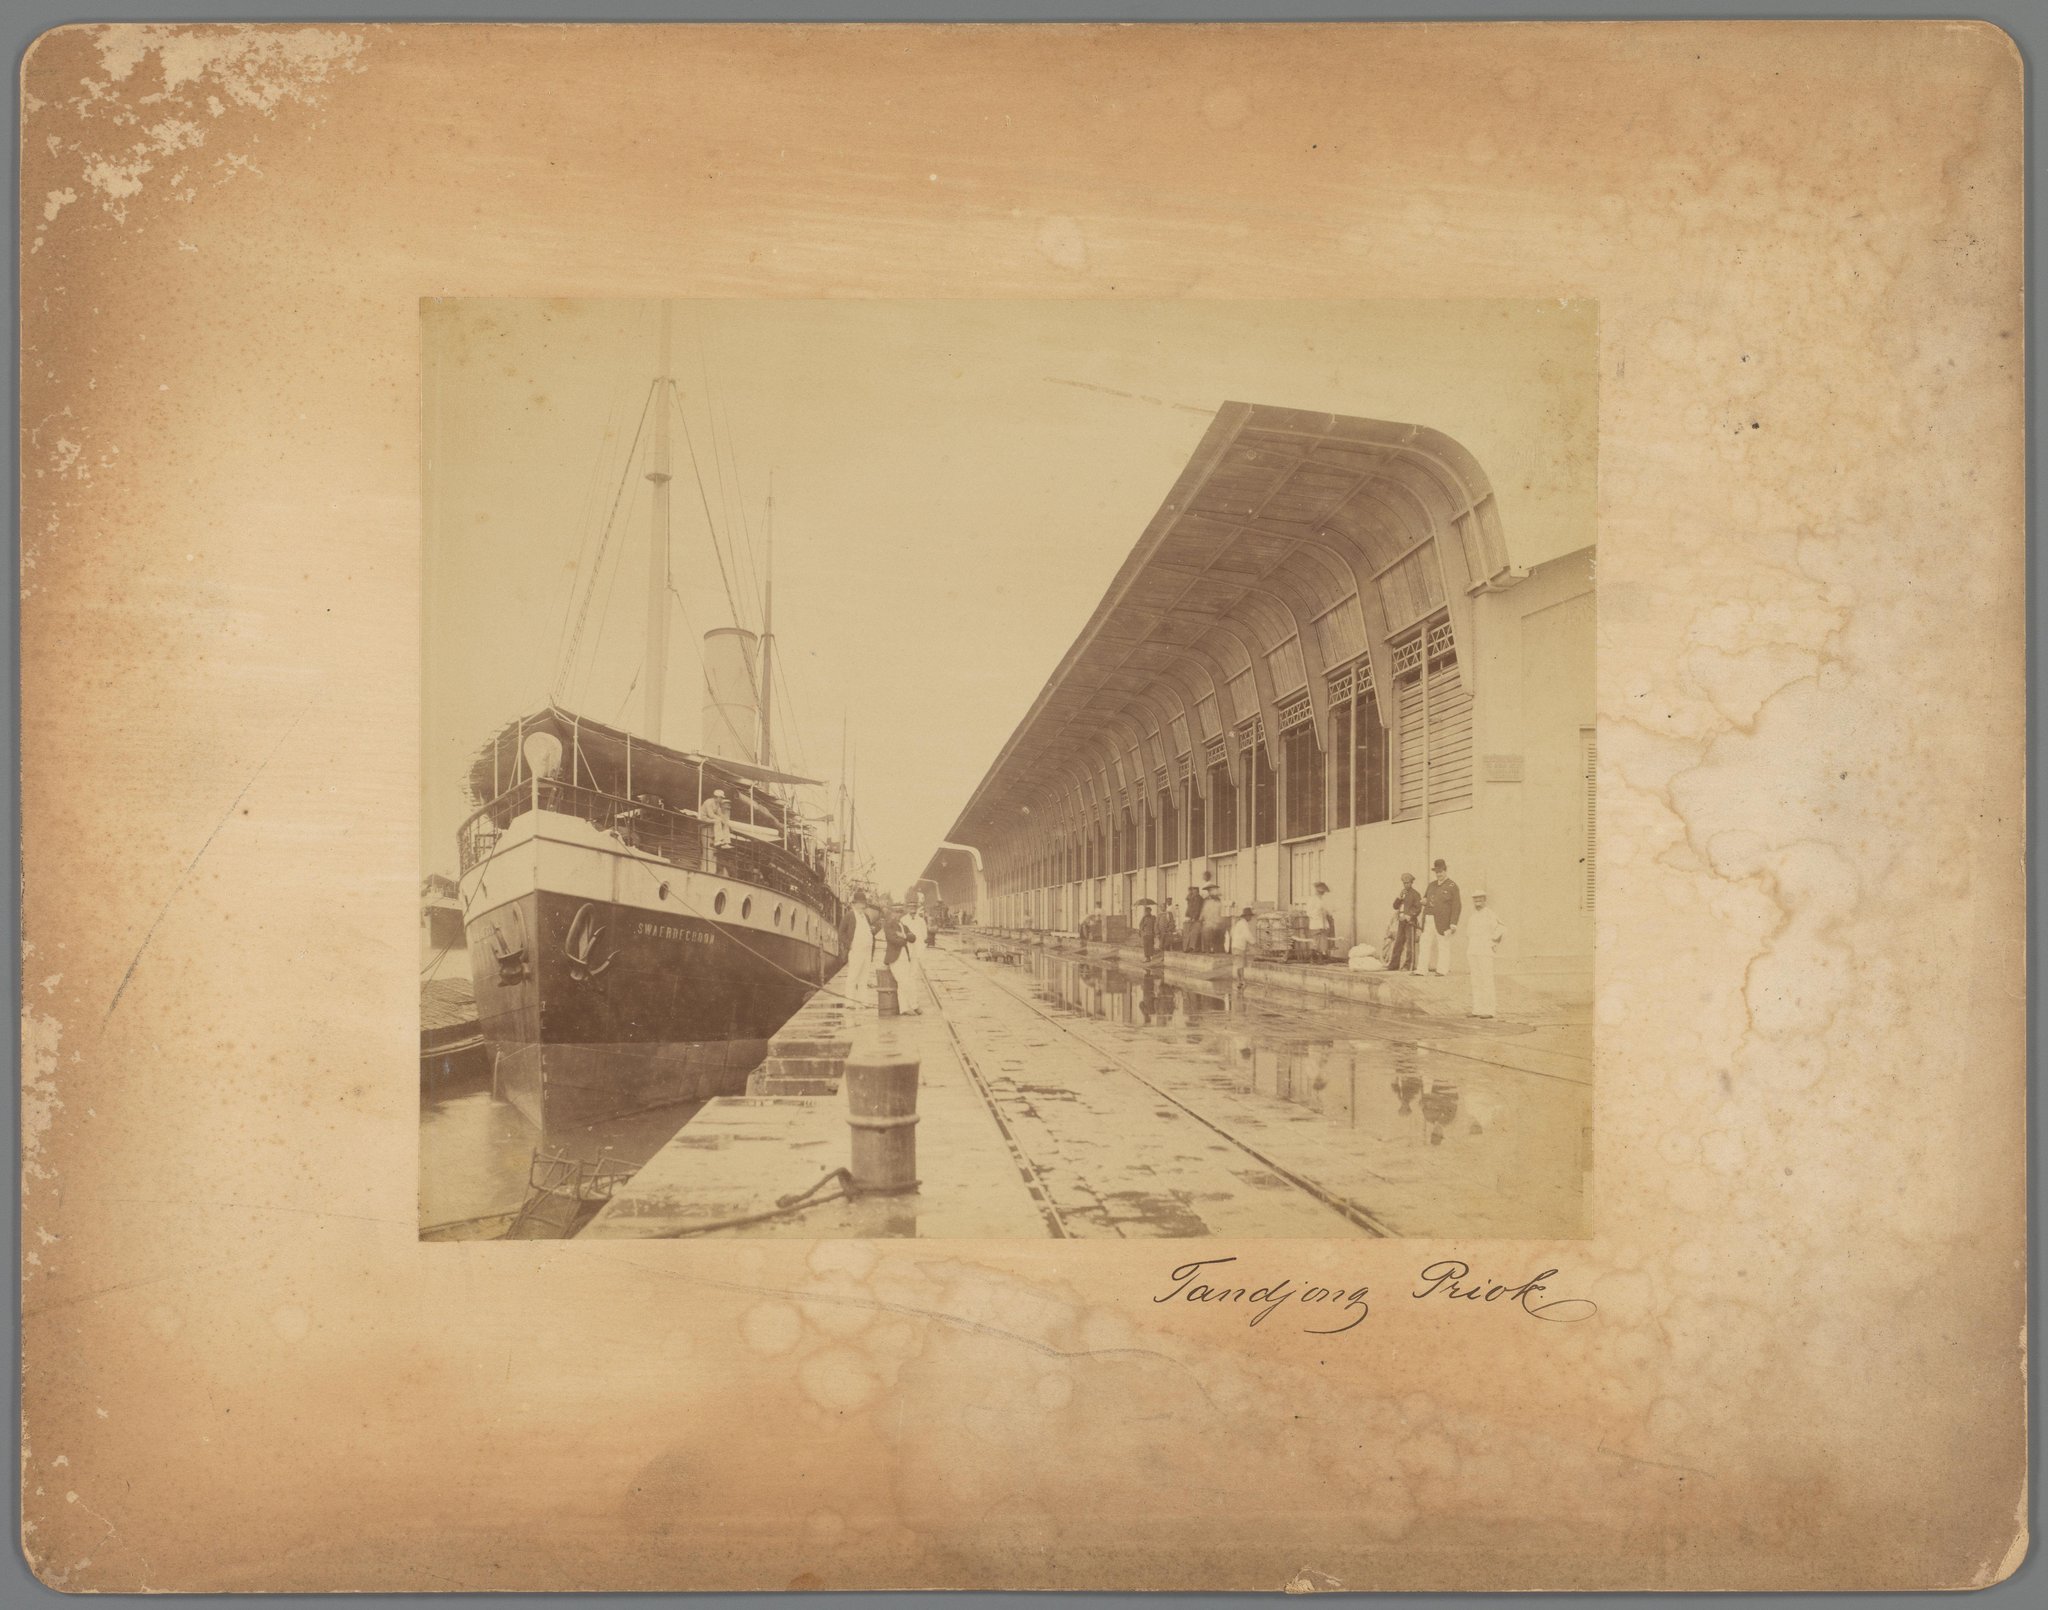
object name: photograph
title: Tandjong Priok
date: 1909-1910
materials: cardboard, paper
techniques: albumen print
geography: tanjung priok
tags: harbour, steamship, motorship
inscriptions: inscription: ‘Foto’, check stamp: ‘Photographieen van Ned. Indië/ W & P/ Batavia’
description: Deze foto zat oorspronkelijk in prentenkabinet RP-F-AA3192.